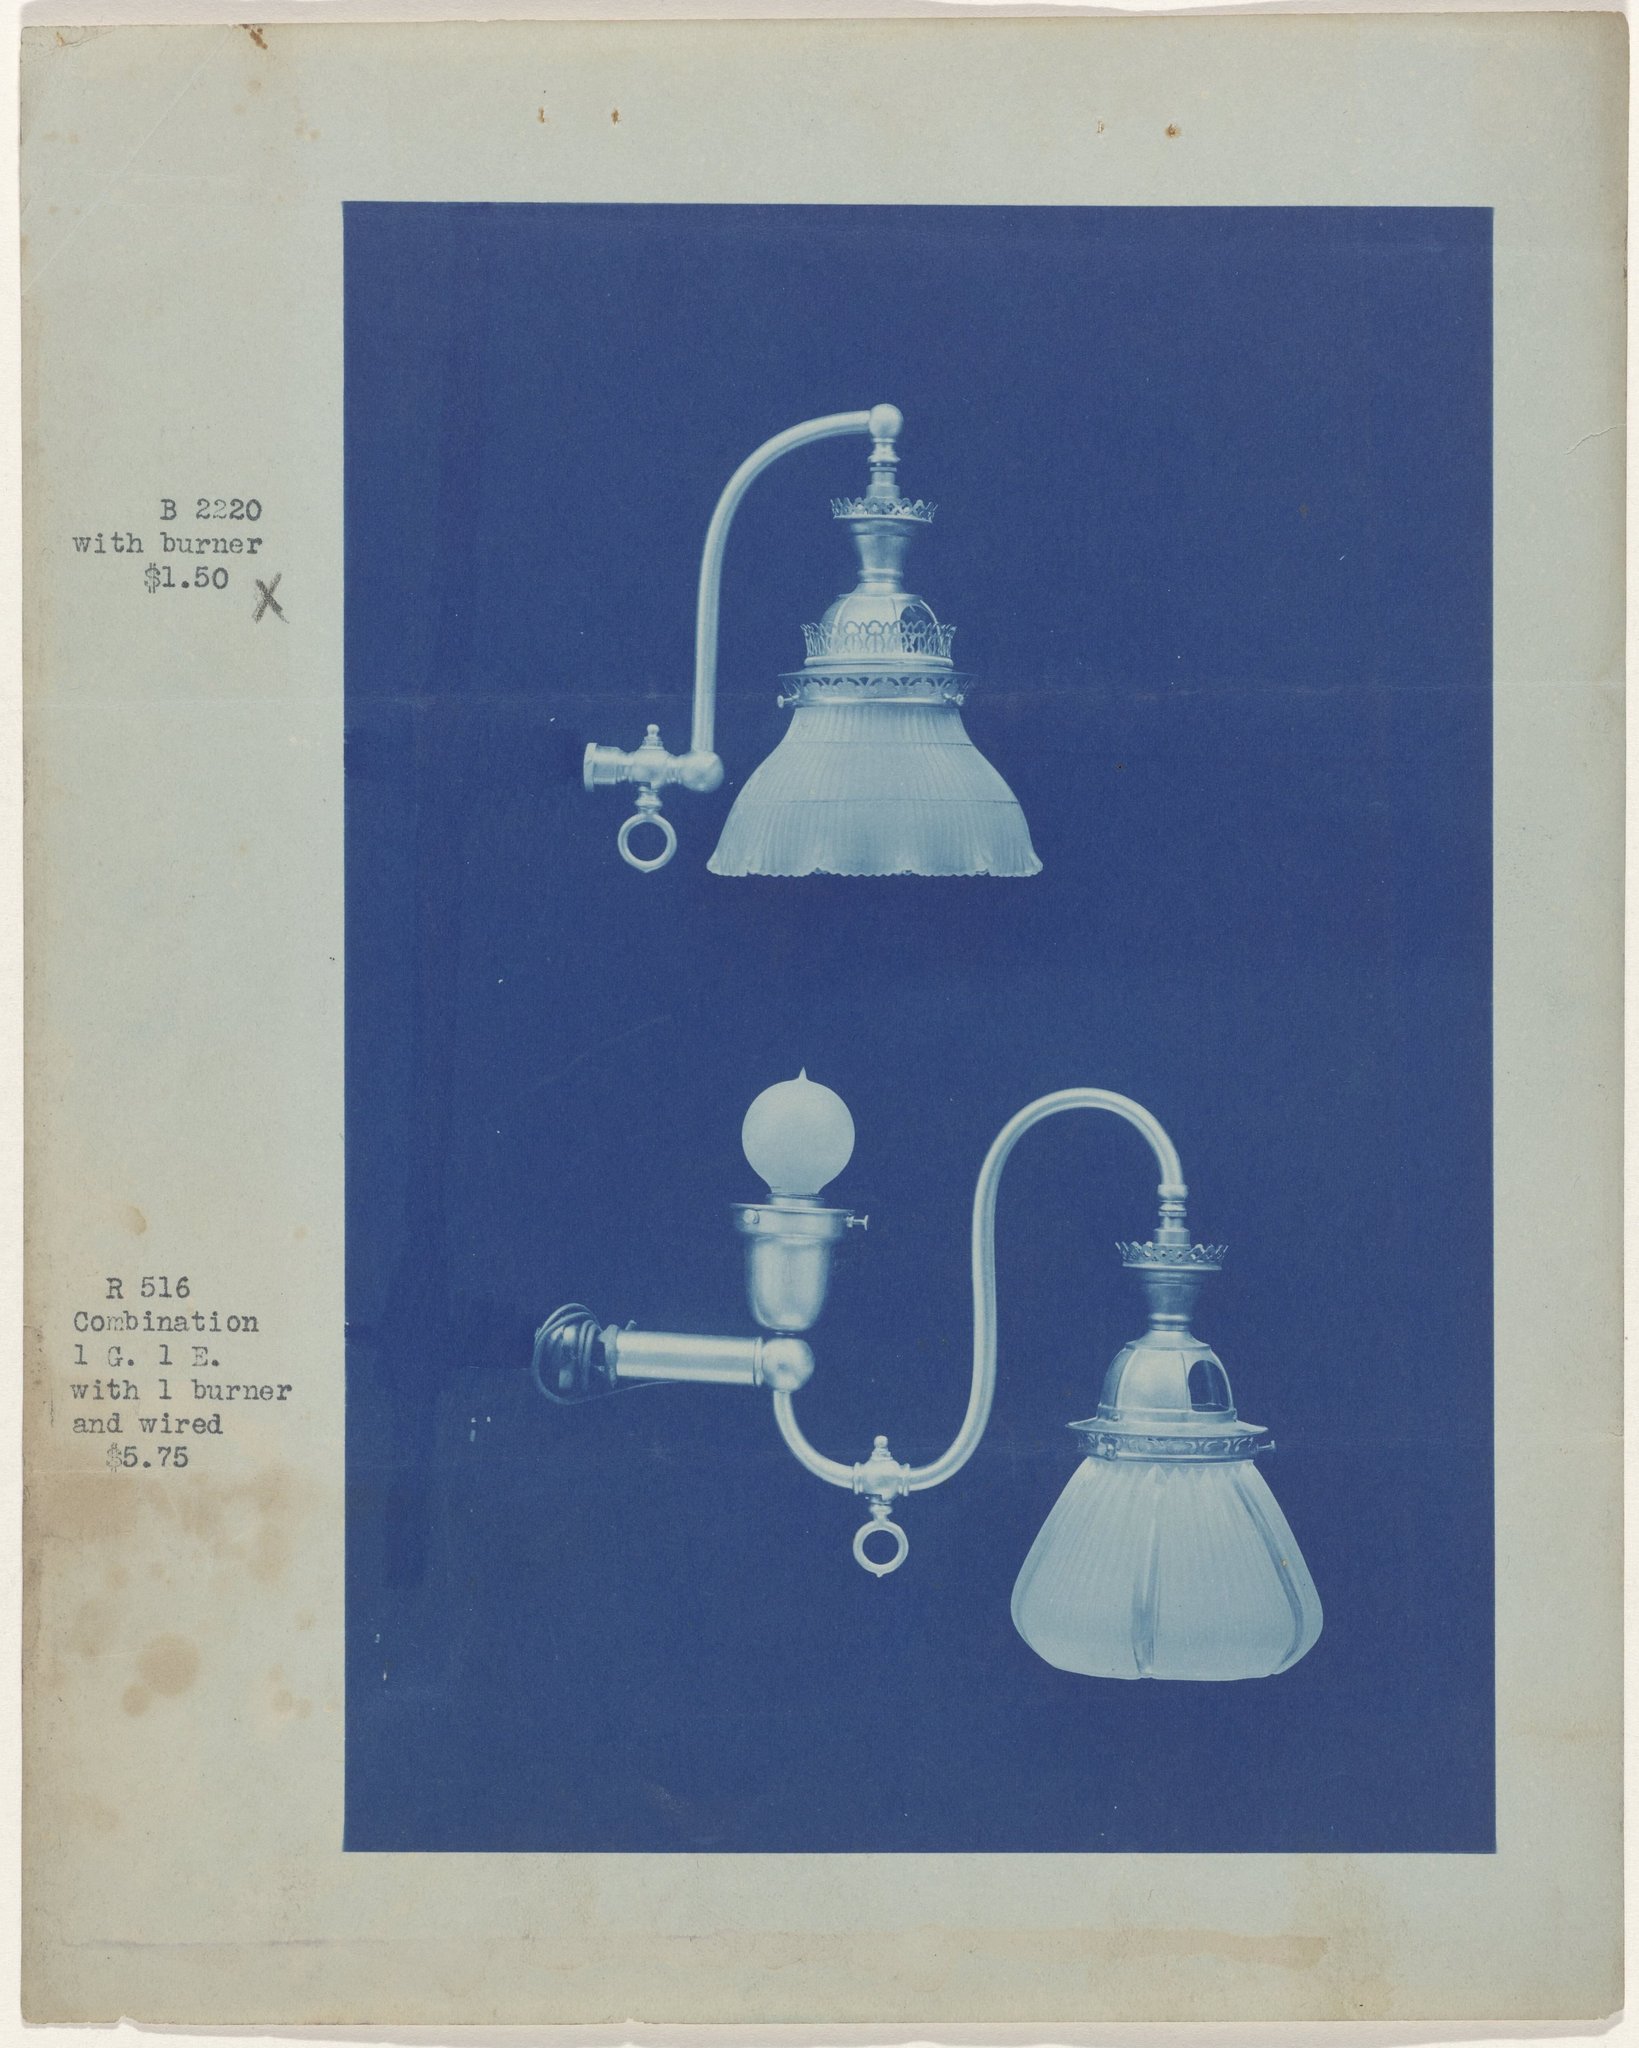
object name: photograph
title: Twee gaslampen, vermoedelijk blad uit catalogus van fabrikant of verkoper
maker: Anonymous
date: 1907-1930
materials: paper, photographic support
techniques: cyanotype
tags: gas-lamp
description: Twee gaslampen, vermoedelijk een blad uit de catalogus van een fabrikant of verkoper. Met teksten in het Engels en prijzen in Amerikaanse dollars.